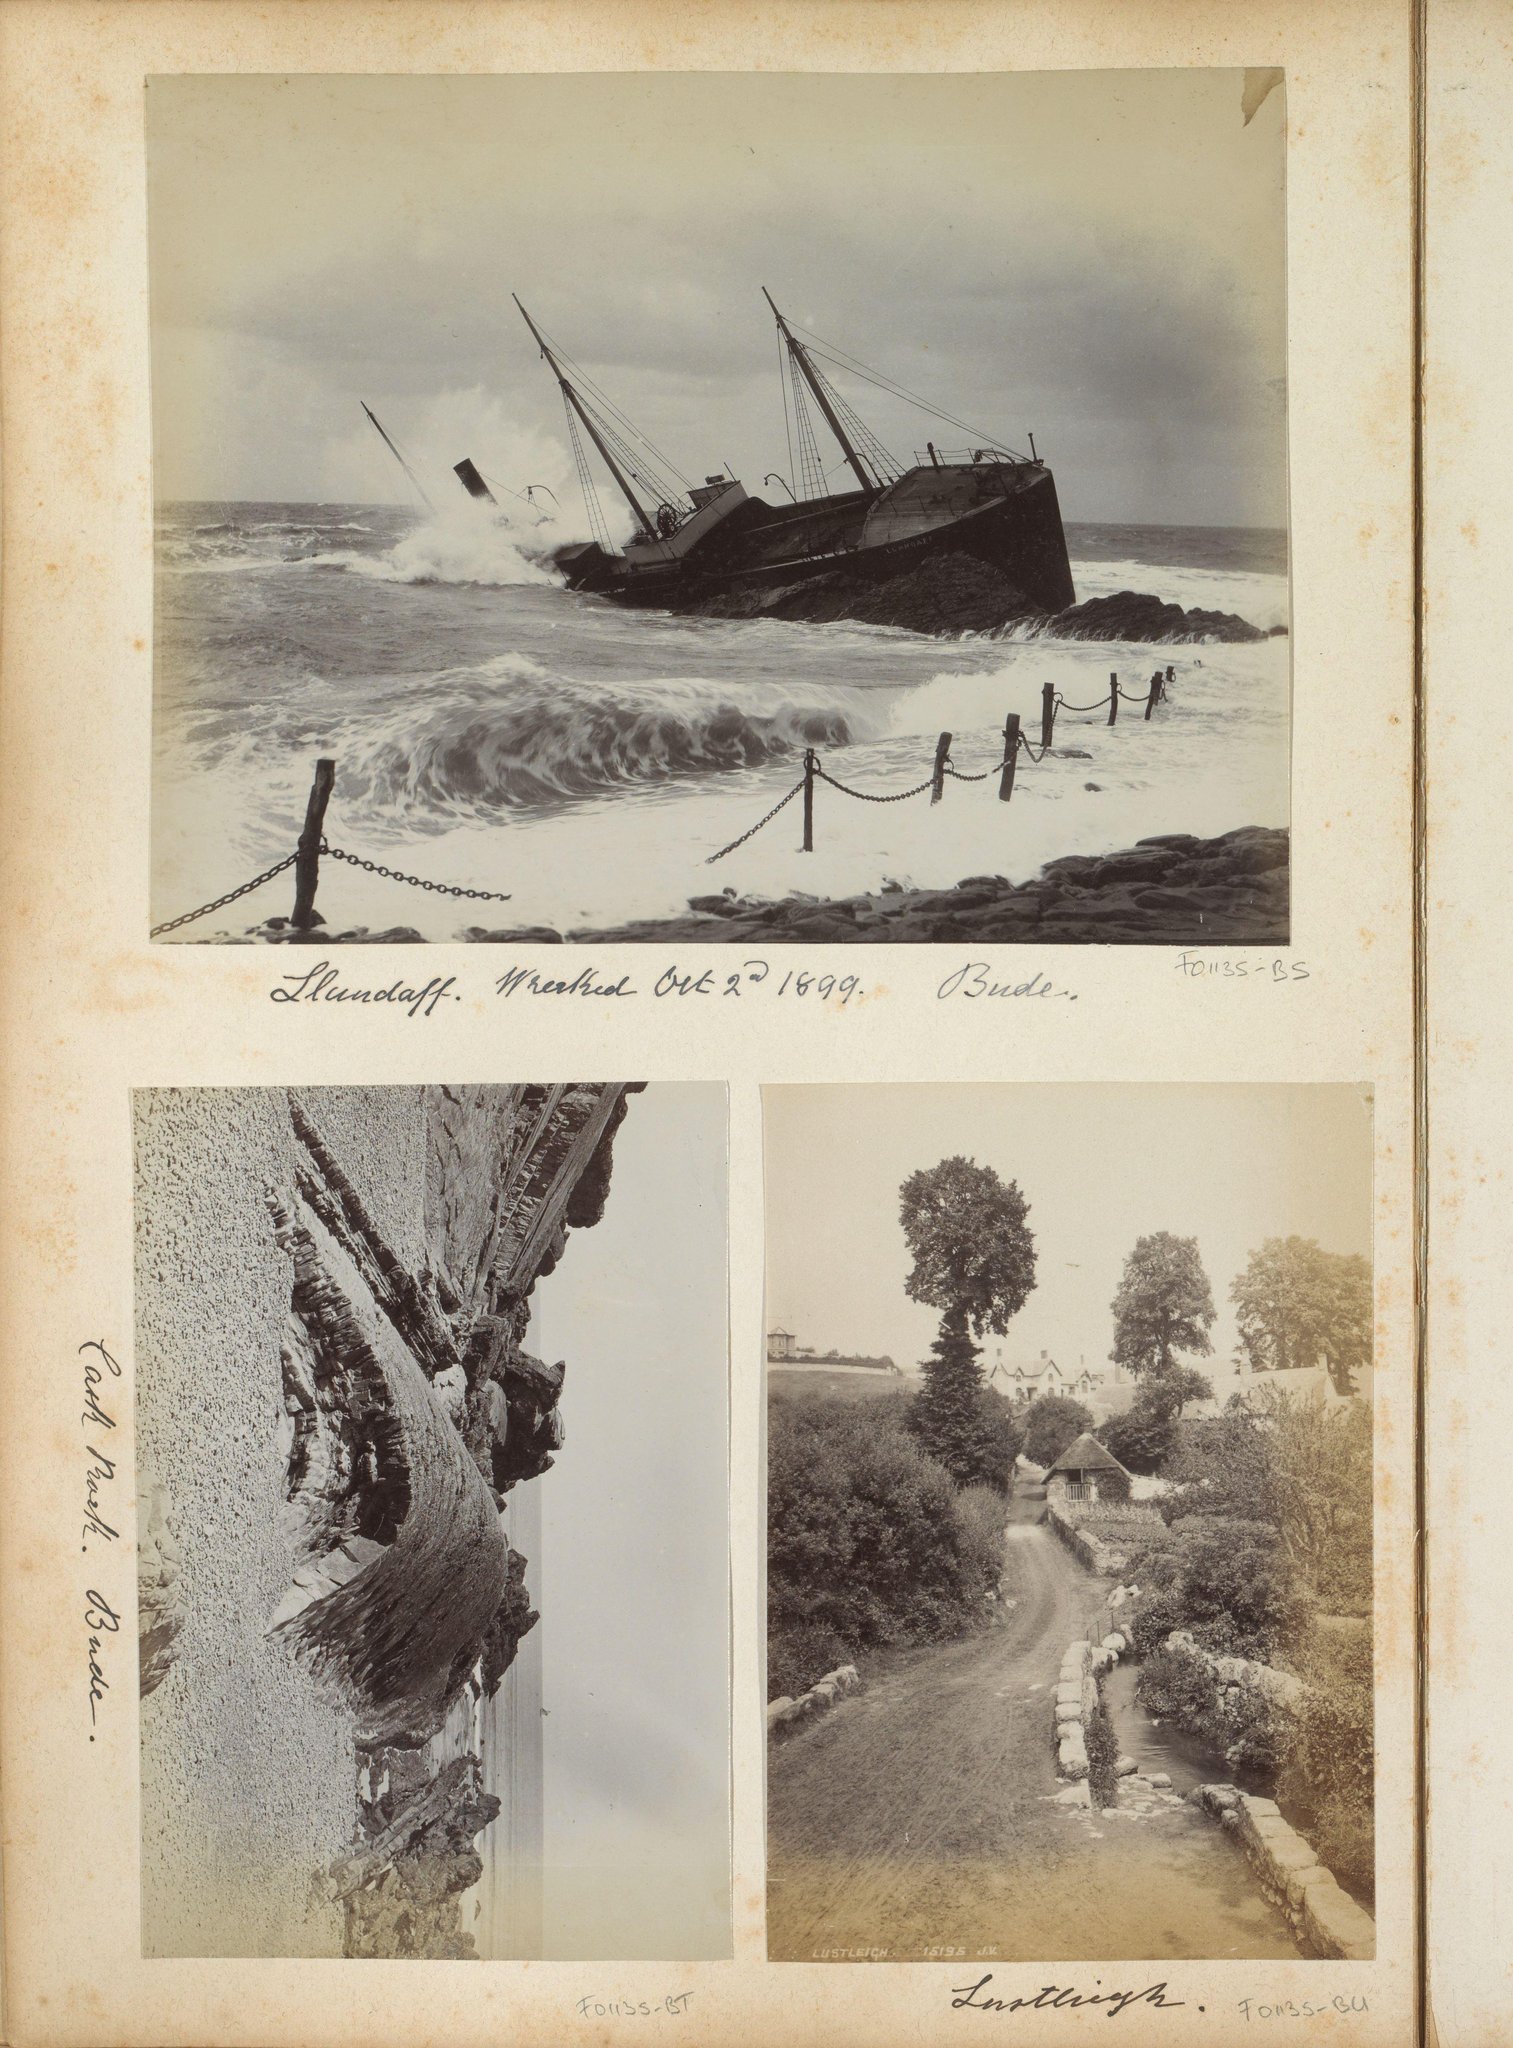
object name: album leaf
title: Pad langs een beek in Lustleigh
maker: james valentine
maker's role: fotograaf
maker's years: 1815-1880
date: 1899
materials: paper, photographic support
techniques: albumen print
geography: lustleigh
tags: prospect of village, silhouette of village, road, path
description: Onderdeel van Reisalbum met foto's van bezienswaardigheden in Engeland en Frankrijk.